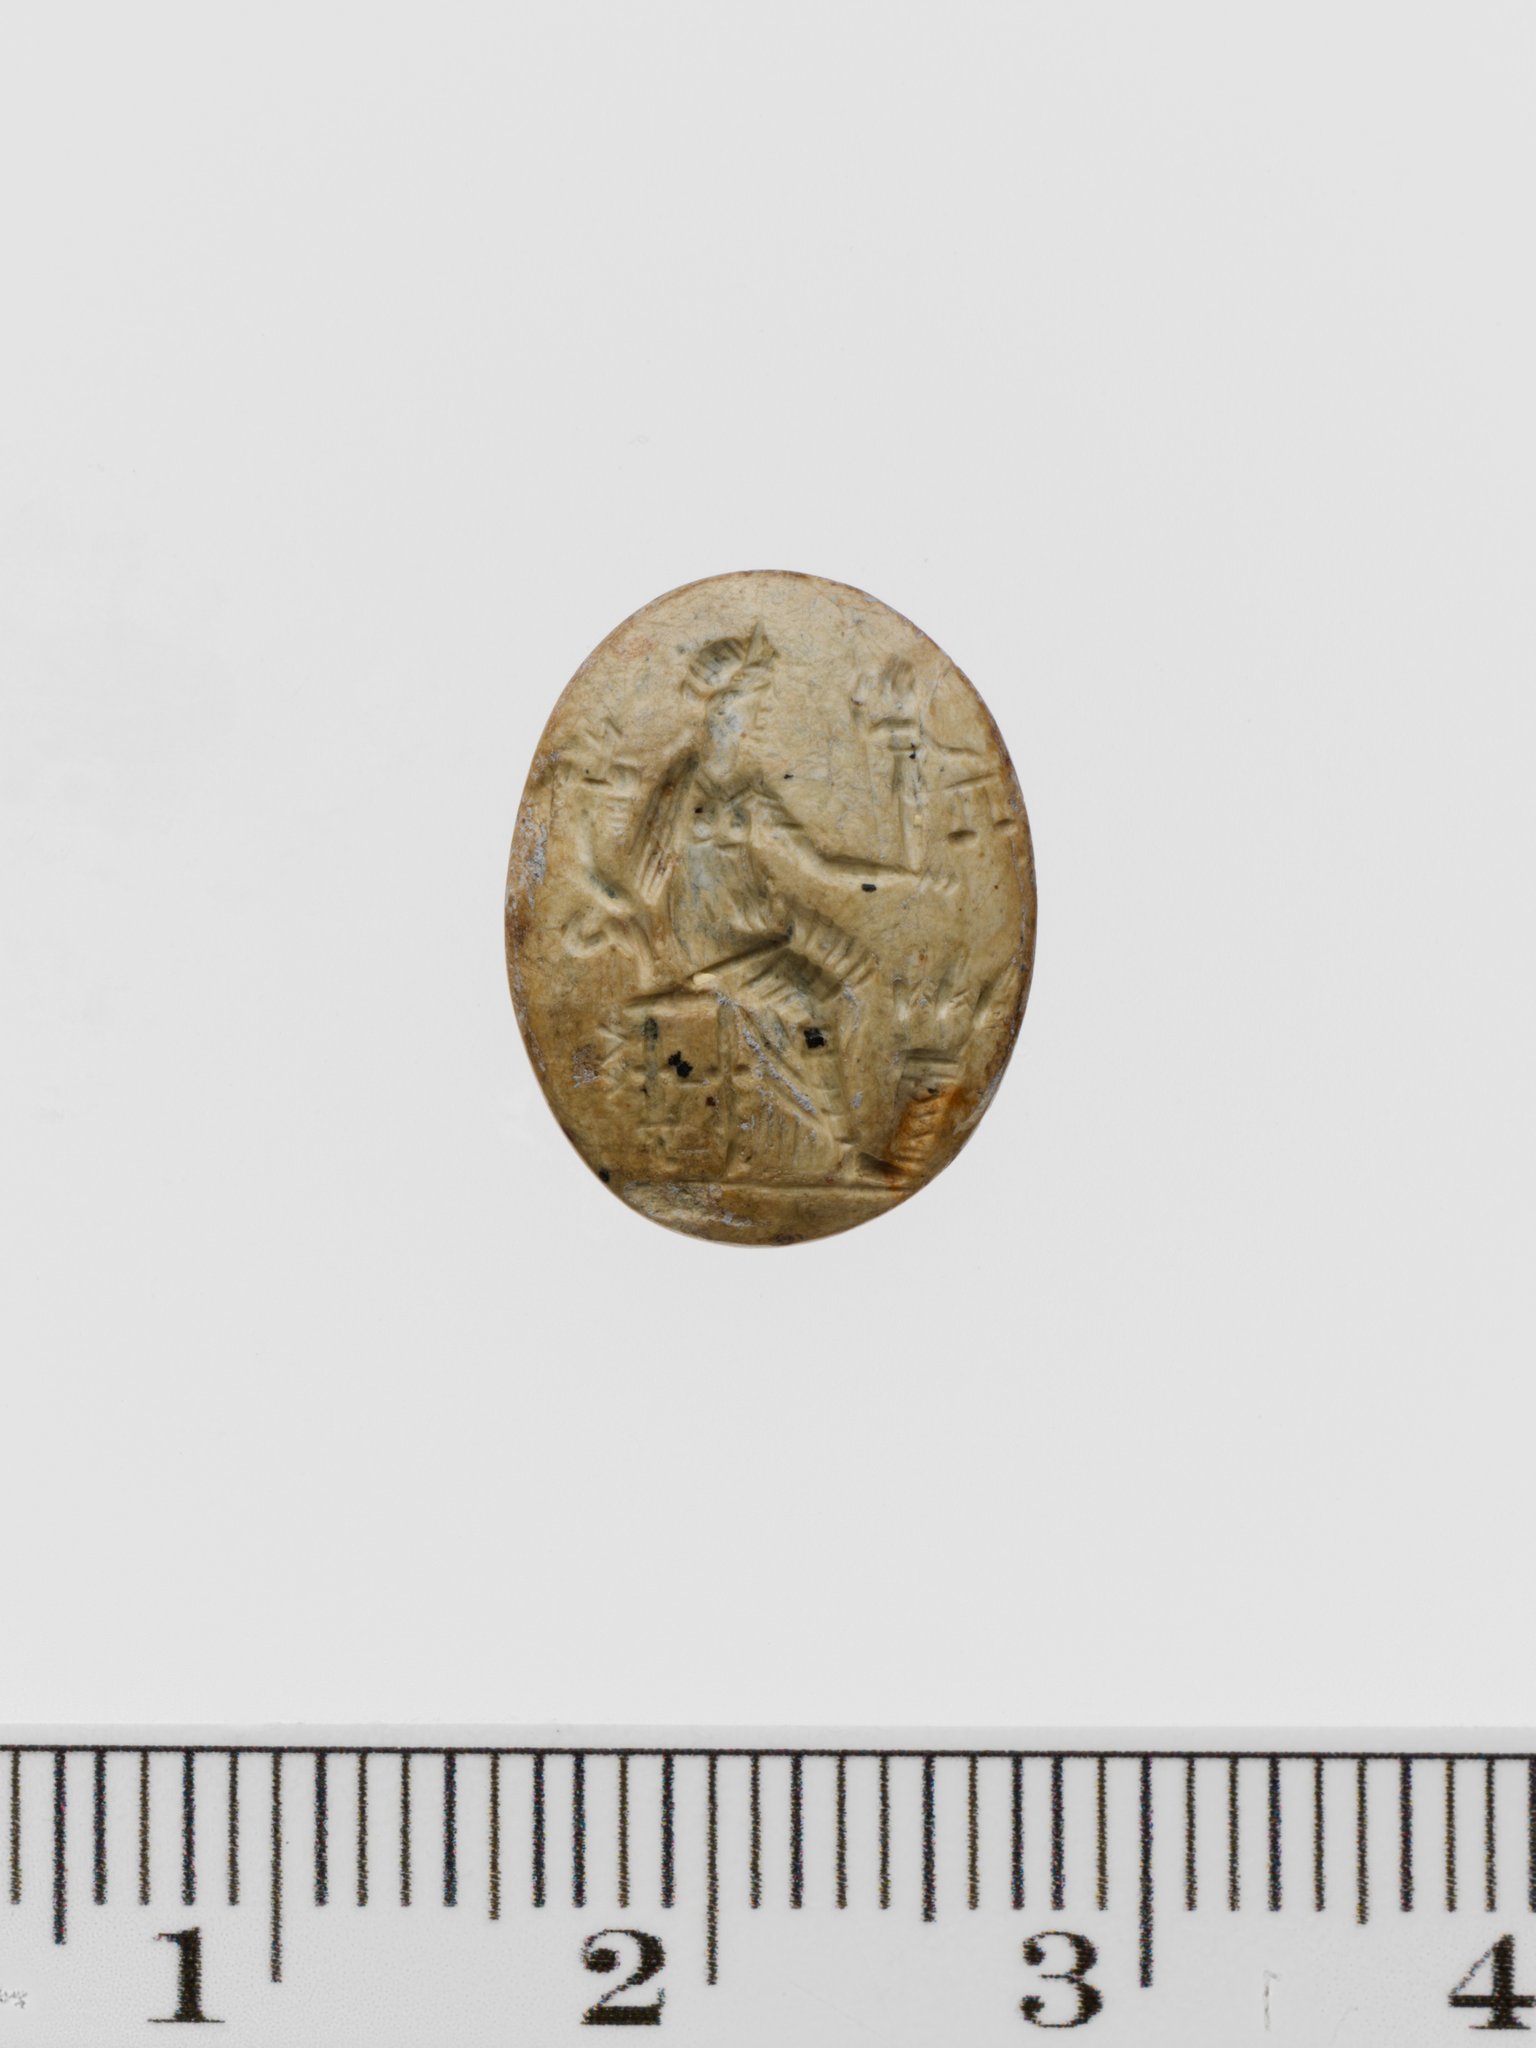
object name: intaglio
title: Sard ring stone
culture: roman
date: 1-100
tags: goddess